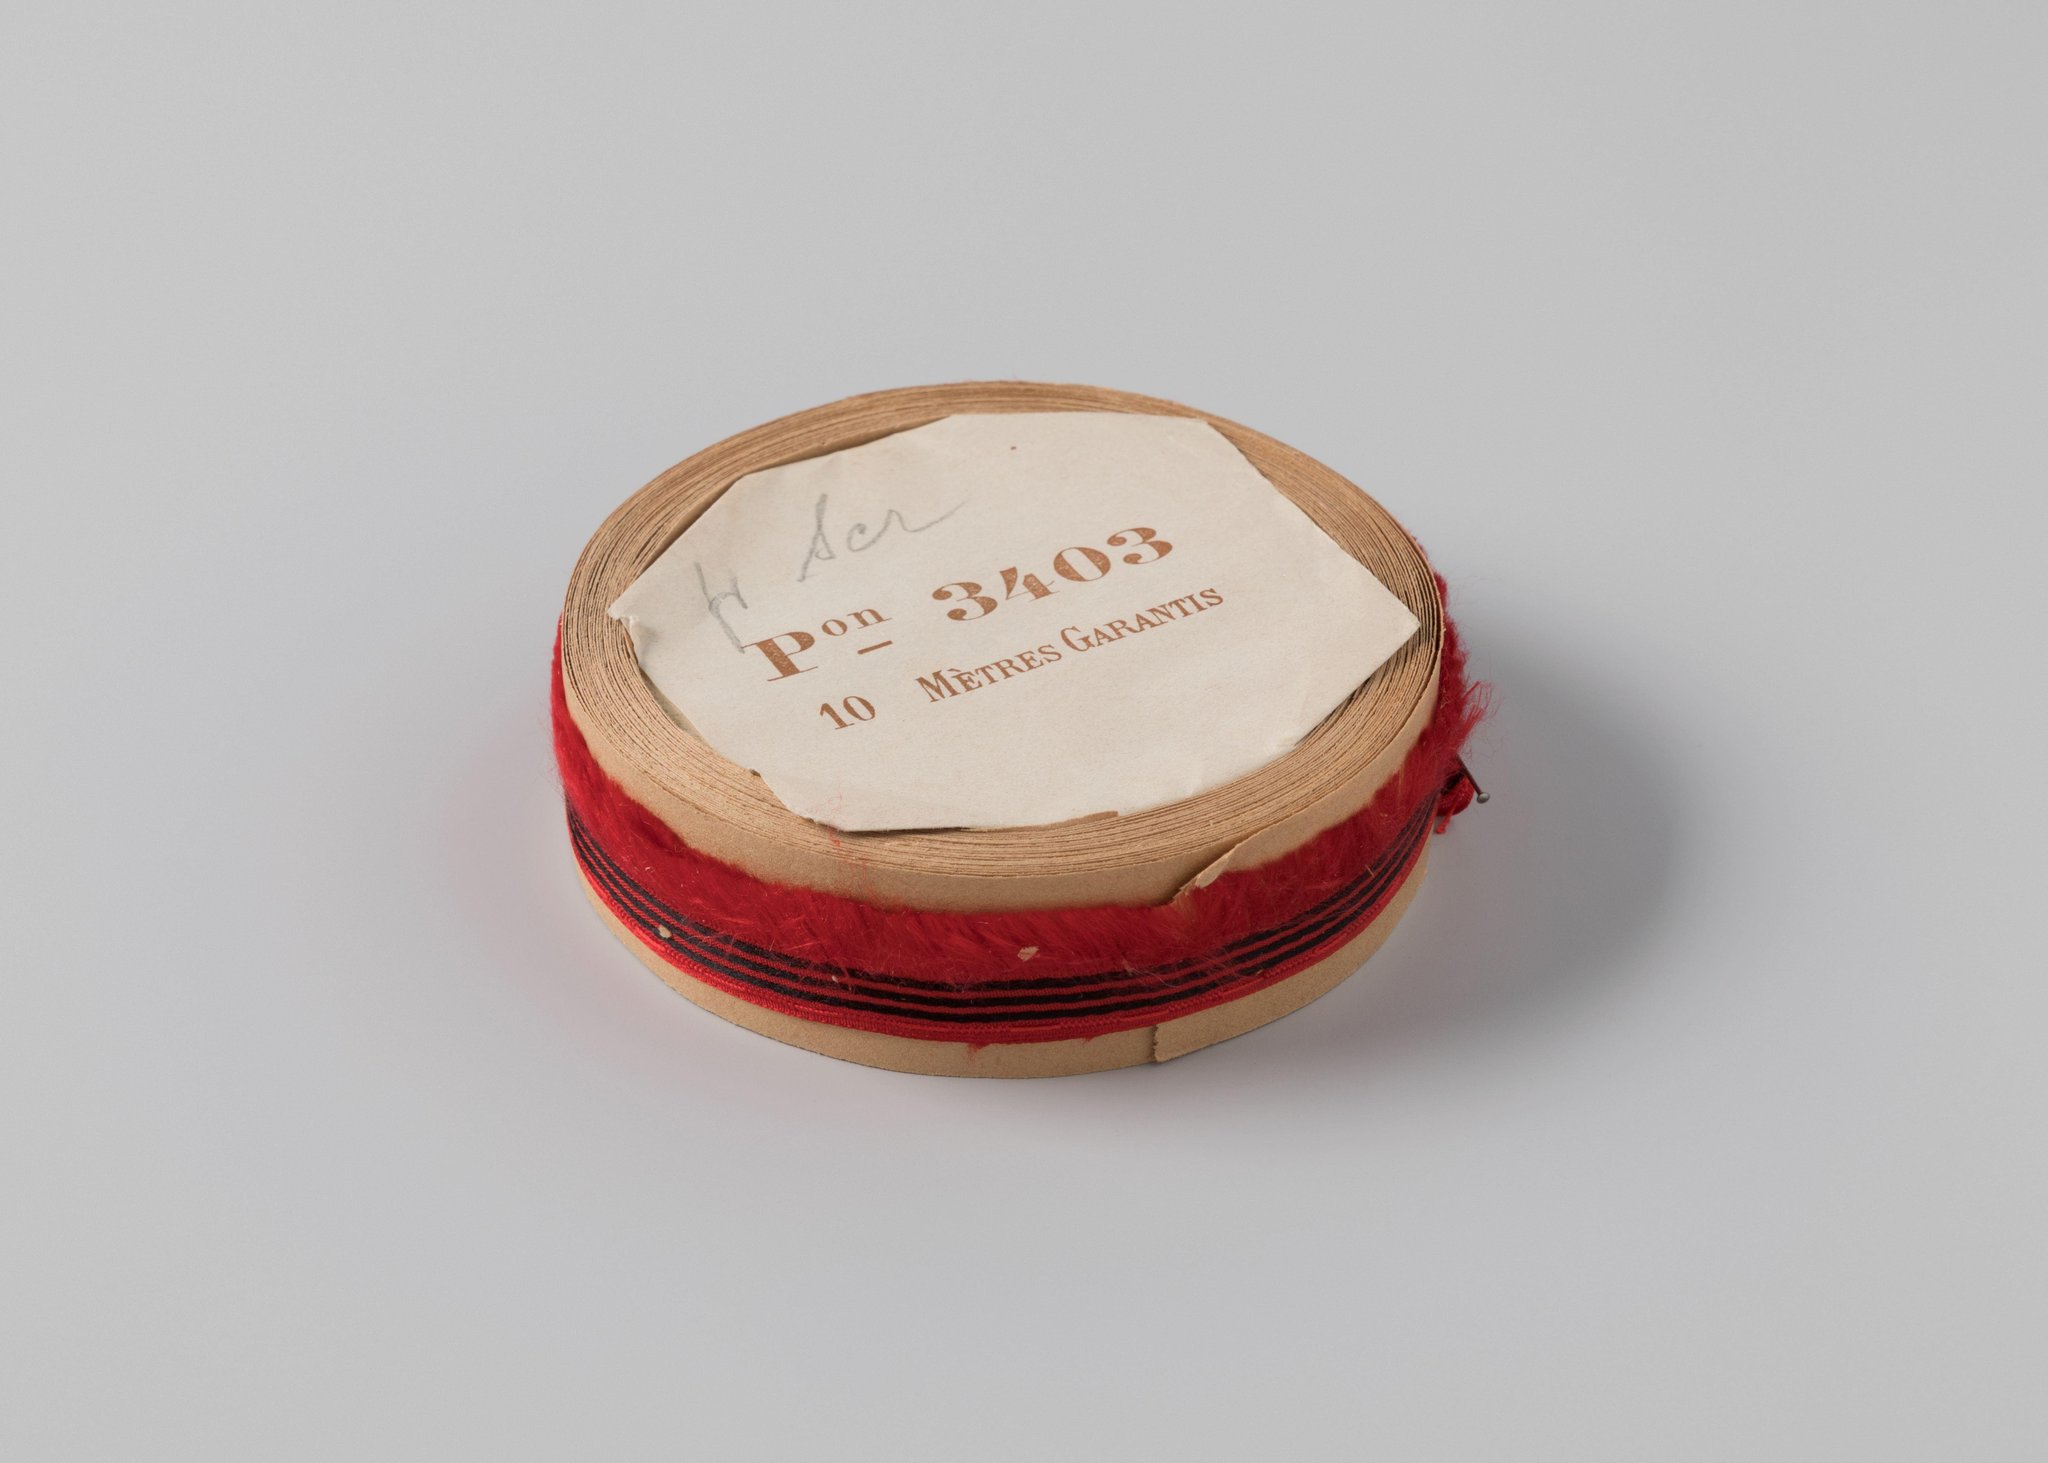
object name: ribbon material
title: Rol met rood lint met één gerafelde zijde en drie zwarte horizontale strepen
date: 1935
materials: cardboard, paper, textile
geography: france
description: Rol met rood lint met één gerafelde zijde en drie zwarte horizontale strepen.